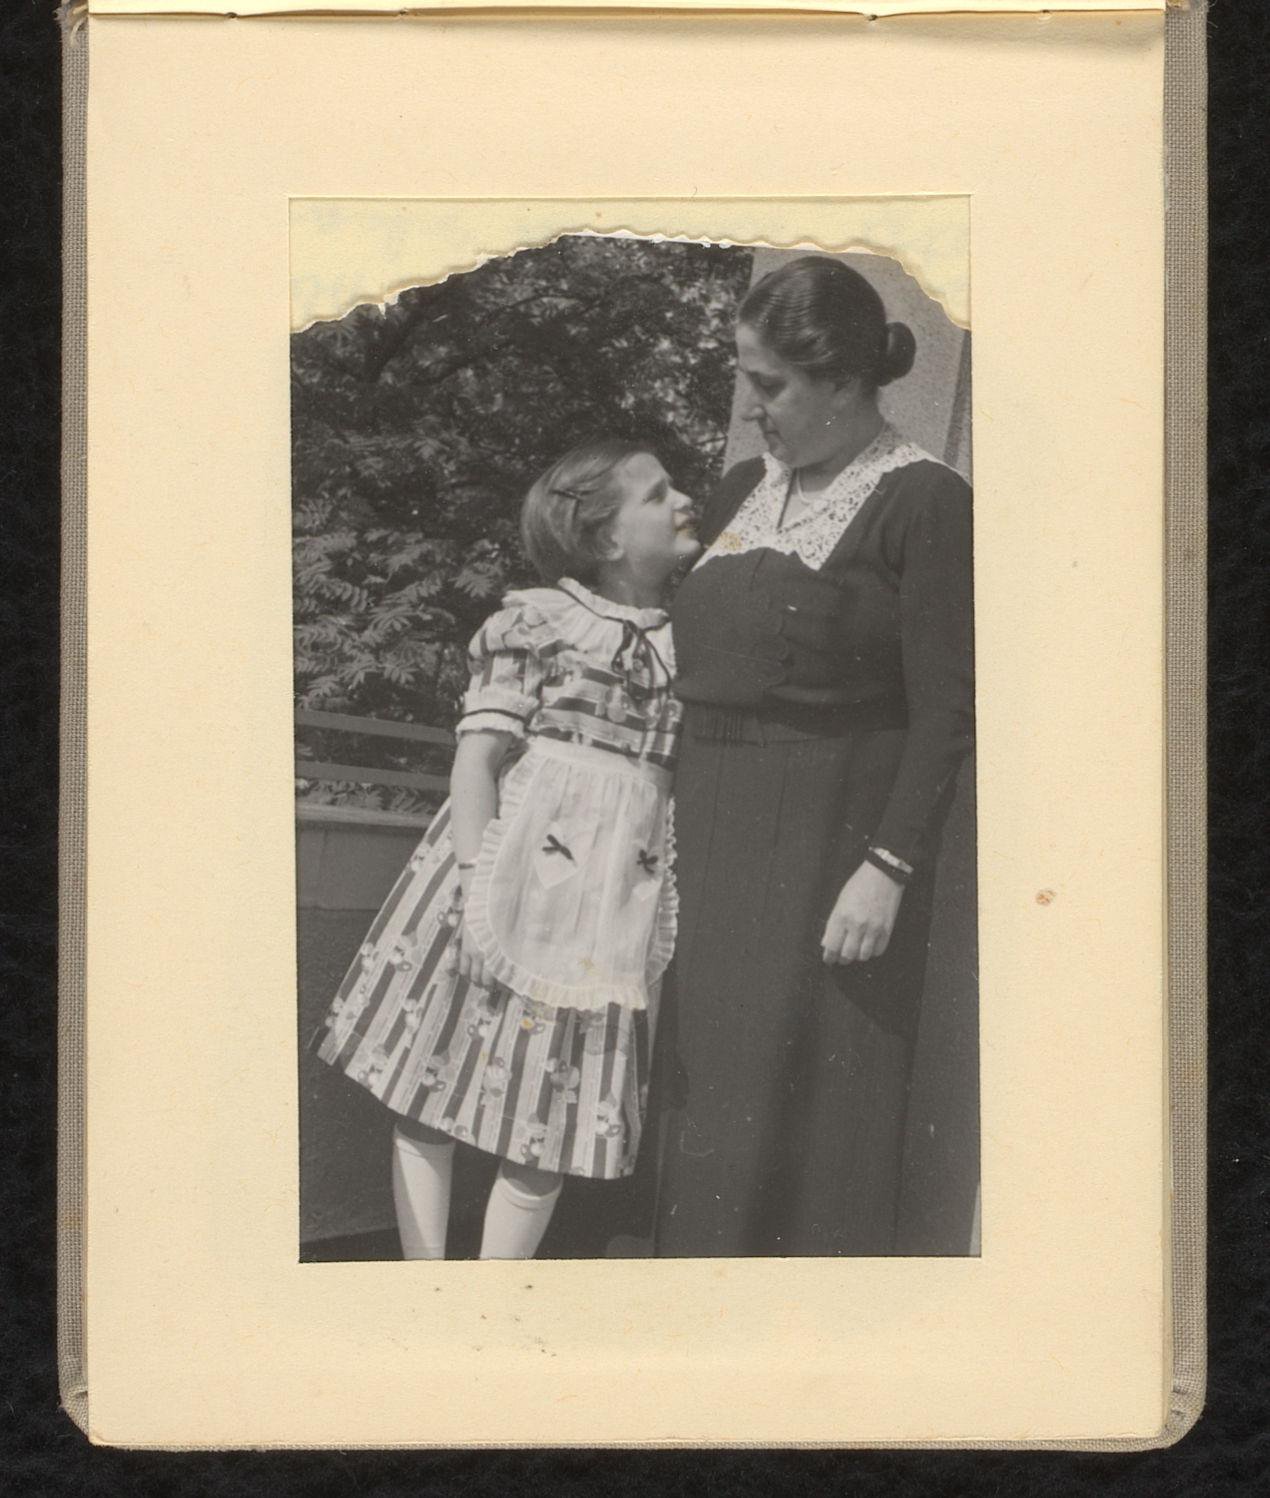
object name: album leaf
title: Isabel Wachenheimer kijkt naar haar moeder Else Wachenheimer-Moos in de tuin, 1933-1937, Stuttgart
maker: isabel wachenheimer-elon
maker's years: 1928-2010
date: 1933-1937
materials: paper, photographic support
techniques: gelatin silver print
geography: stuttgart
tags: else wachenheimer-moos, leiden, isabel wachenheimer-elon, mother and daughter(s) (family group)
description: Albumblad bevat een foto van Isabel Wachenheimer (links) en Else Wachenheimer-Moos (rechts). Onderdeel van het fotoalbum met diverse foto's van de jeugd van Isabel Wachenheimer voor en tijdens de oorlog en diverse momenten van haar volwassen leven na de Tweede Wereldoorlog.